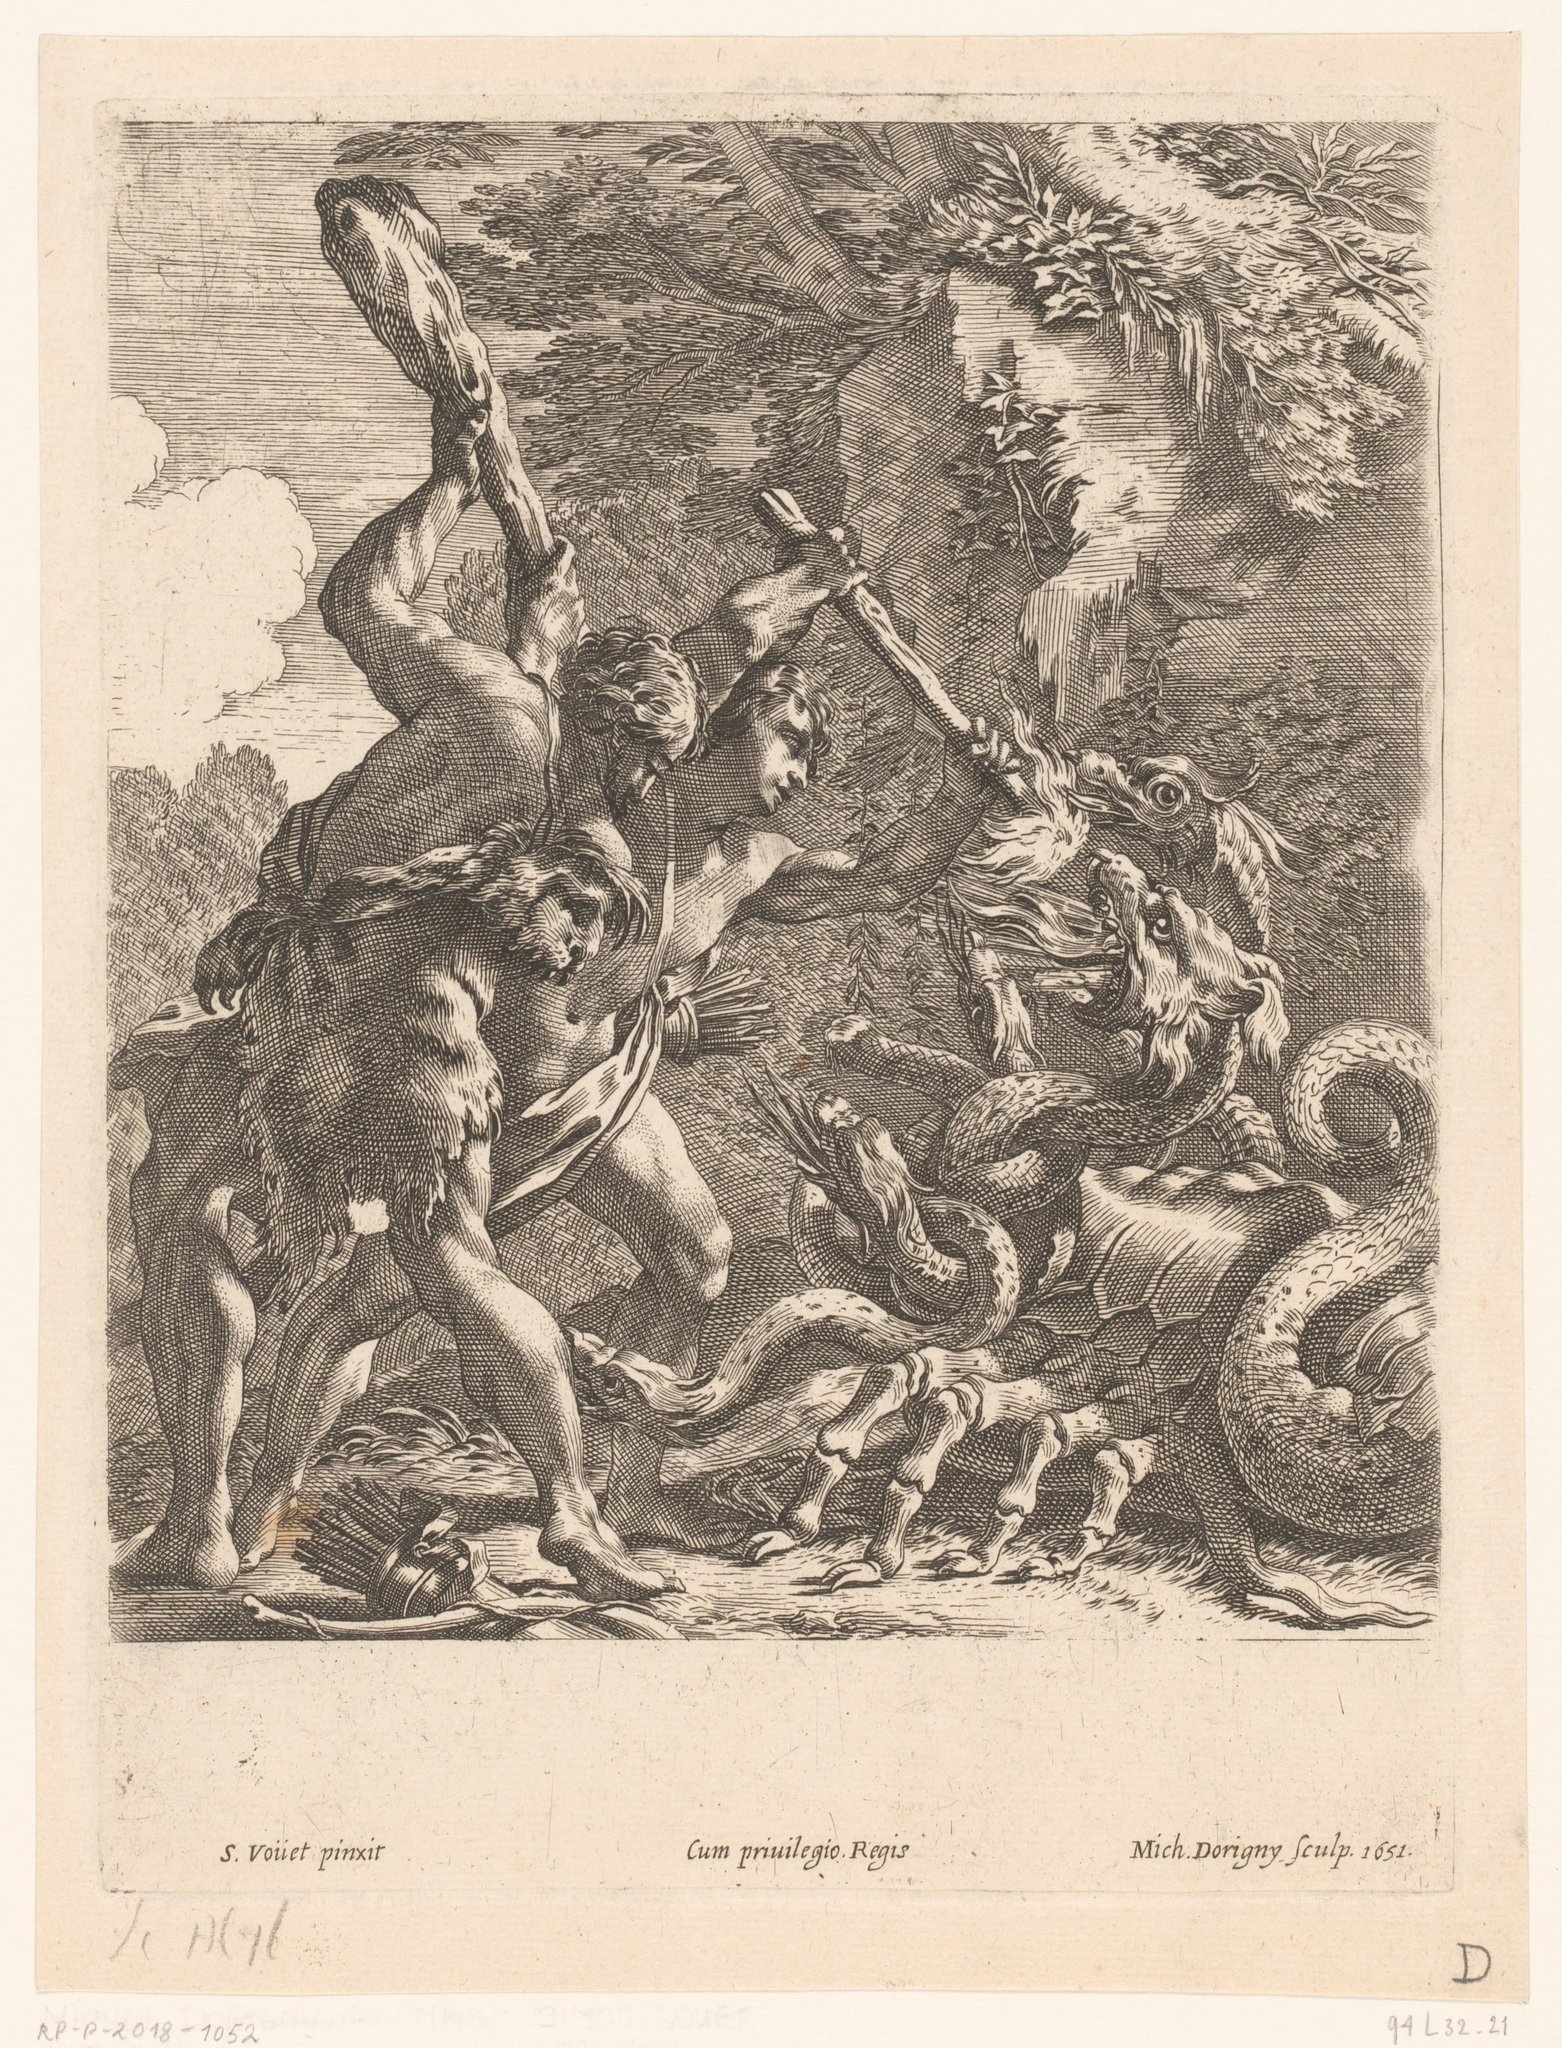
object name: print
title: Hercules doodt de hydra van Lerna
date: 1651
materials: paper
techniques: engraving, etching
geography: france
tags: the hydra is killed by hercules assisted by iolaus, who sears the roots of the severed heads with burning brands; an enormous crab nips hercules' foot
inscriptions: collector's mark: Lugt 2228